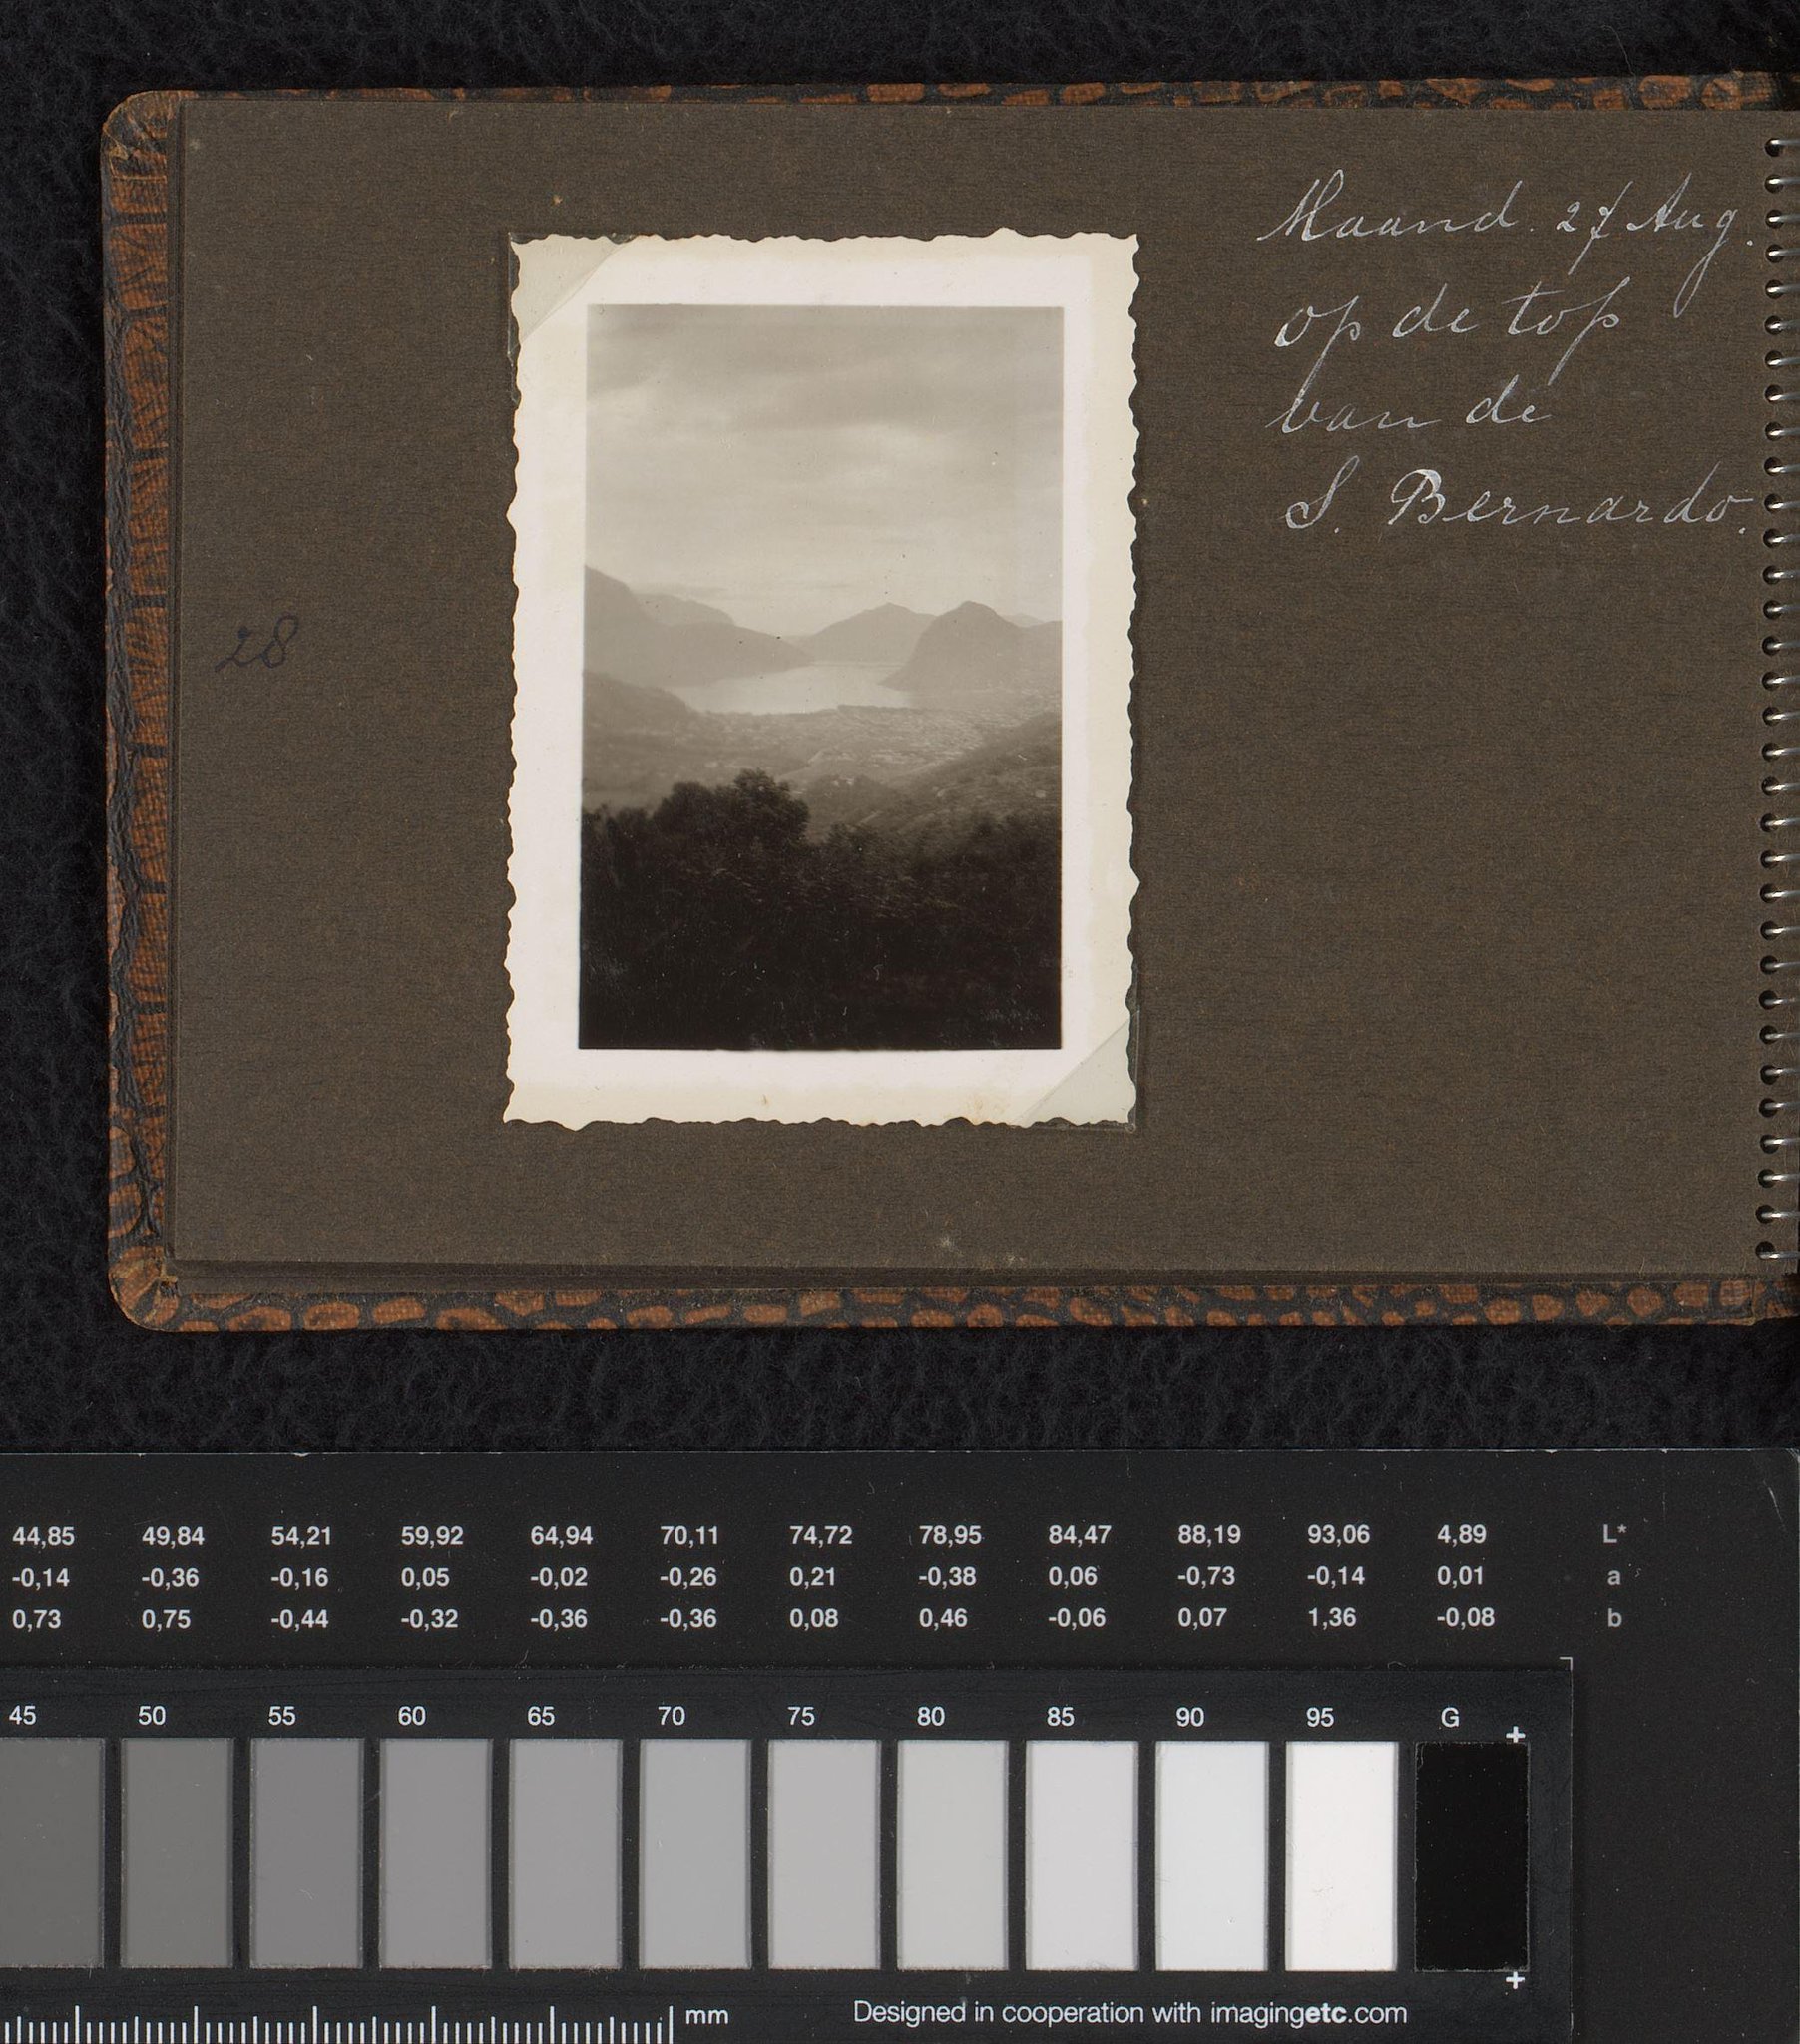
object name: album leaf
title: Op de top van de S. Bernardo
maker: Anonymous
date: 1934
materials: paper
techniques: gelatin silver print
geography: collina di san bernardo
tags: lake, mountains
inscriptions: number: ‘28’